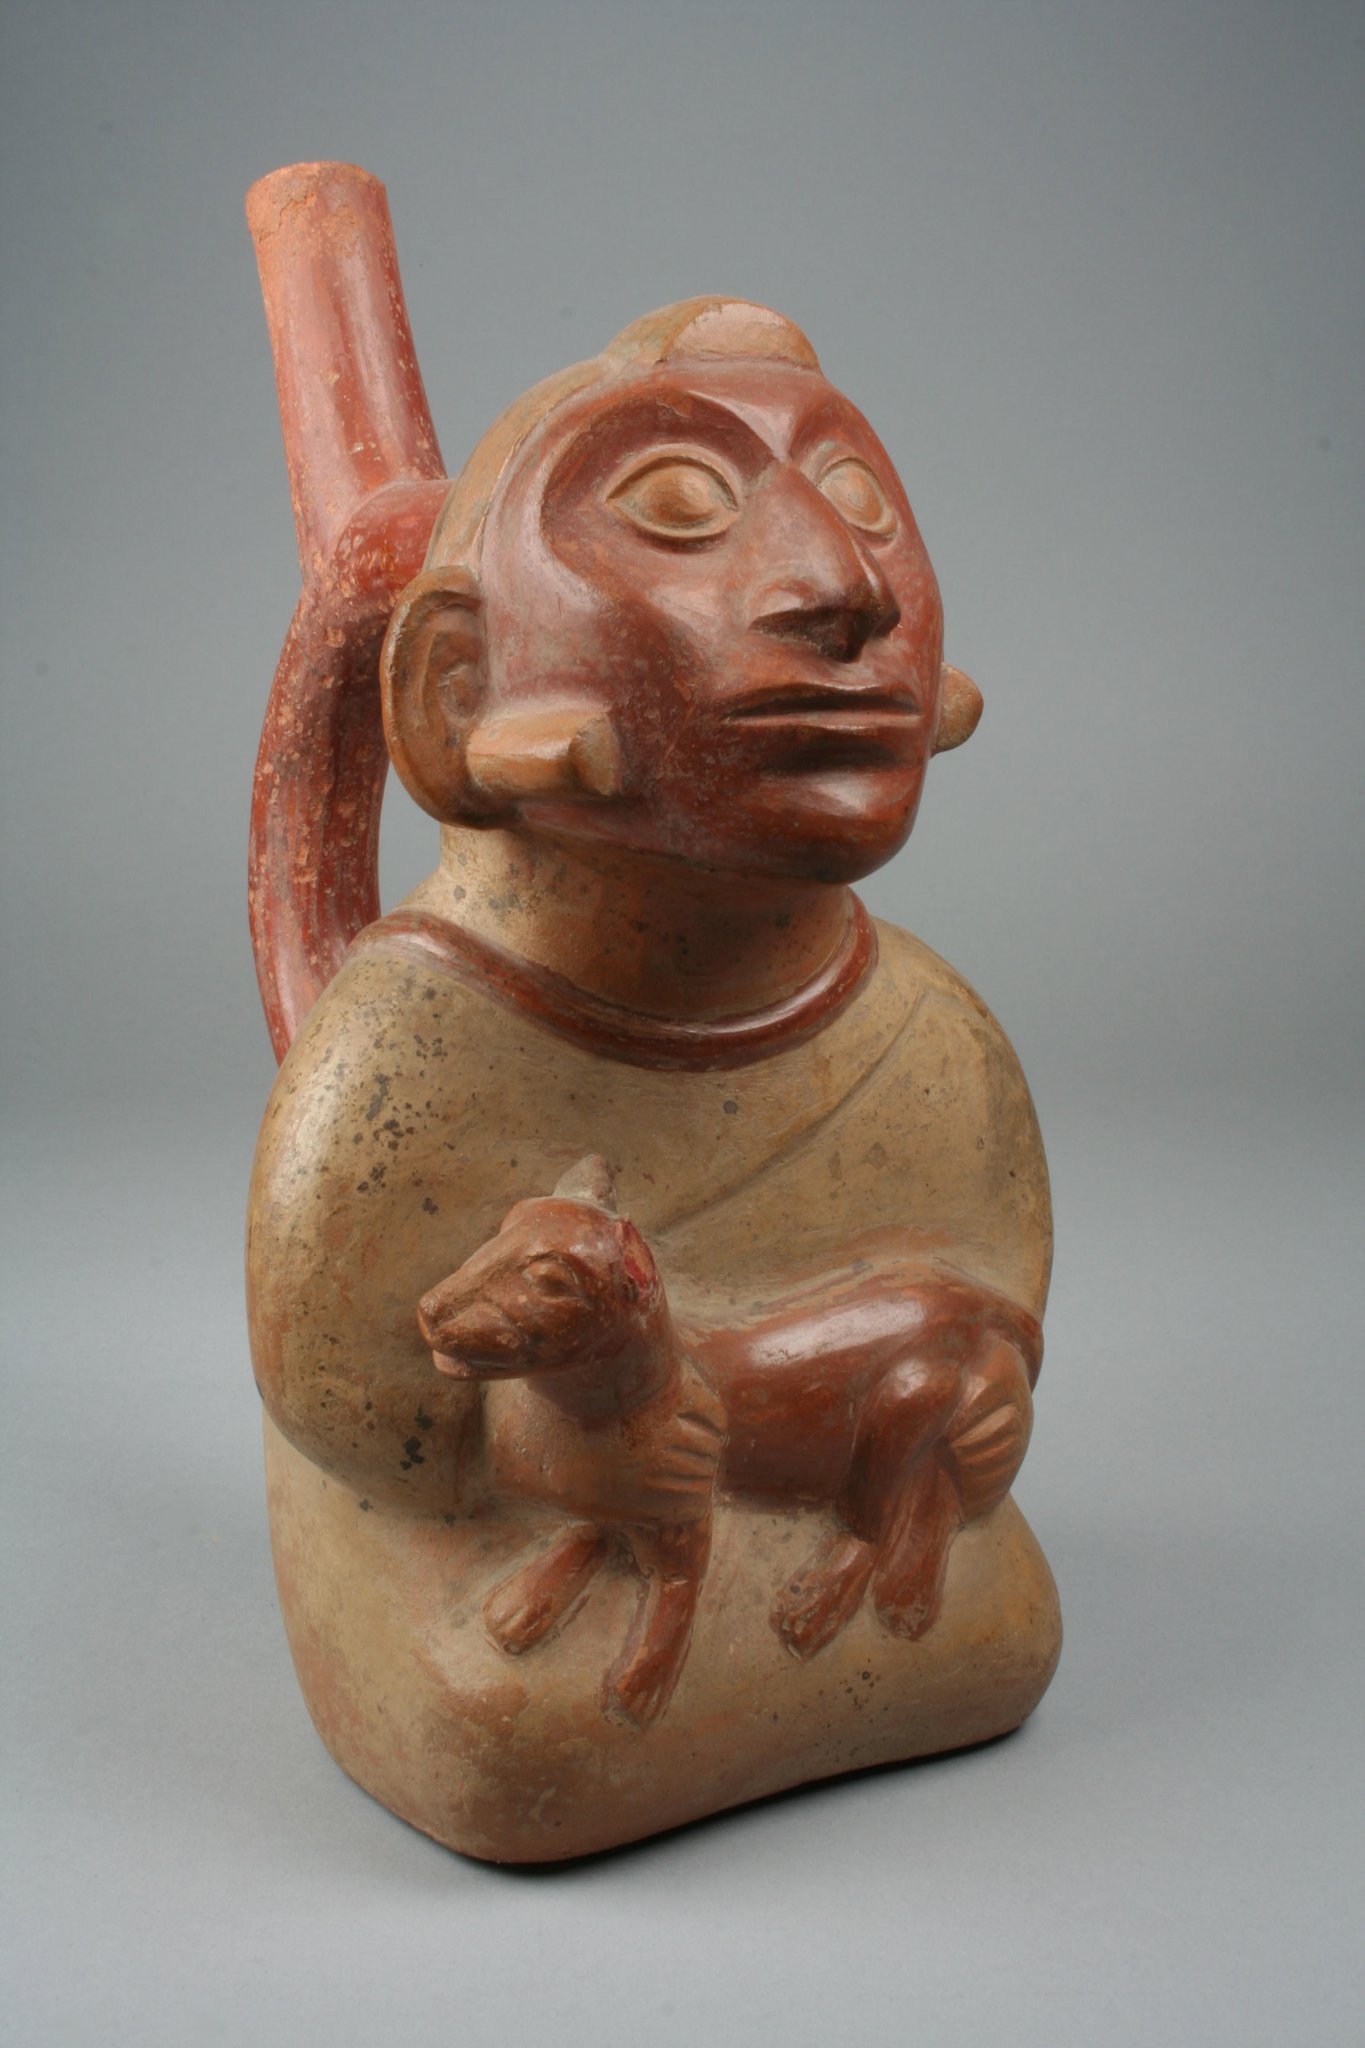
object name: bottle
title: Stirrup Spout Bottle with Figure Holding Feline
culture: moche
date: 301-600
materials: ceramic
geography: peru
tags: human figures,cats